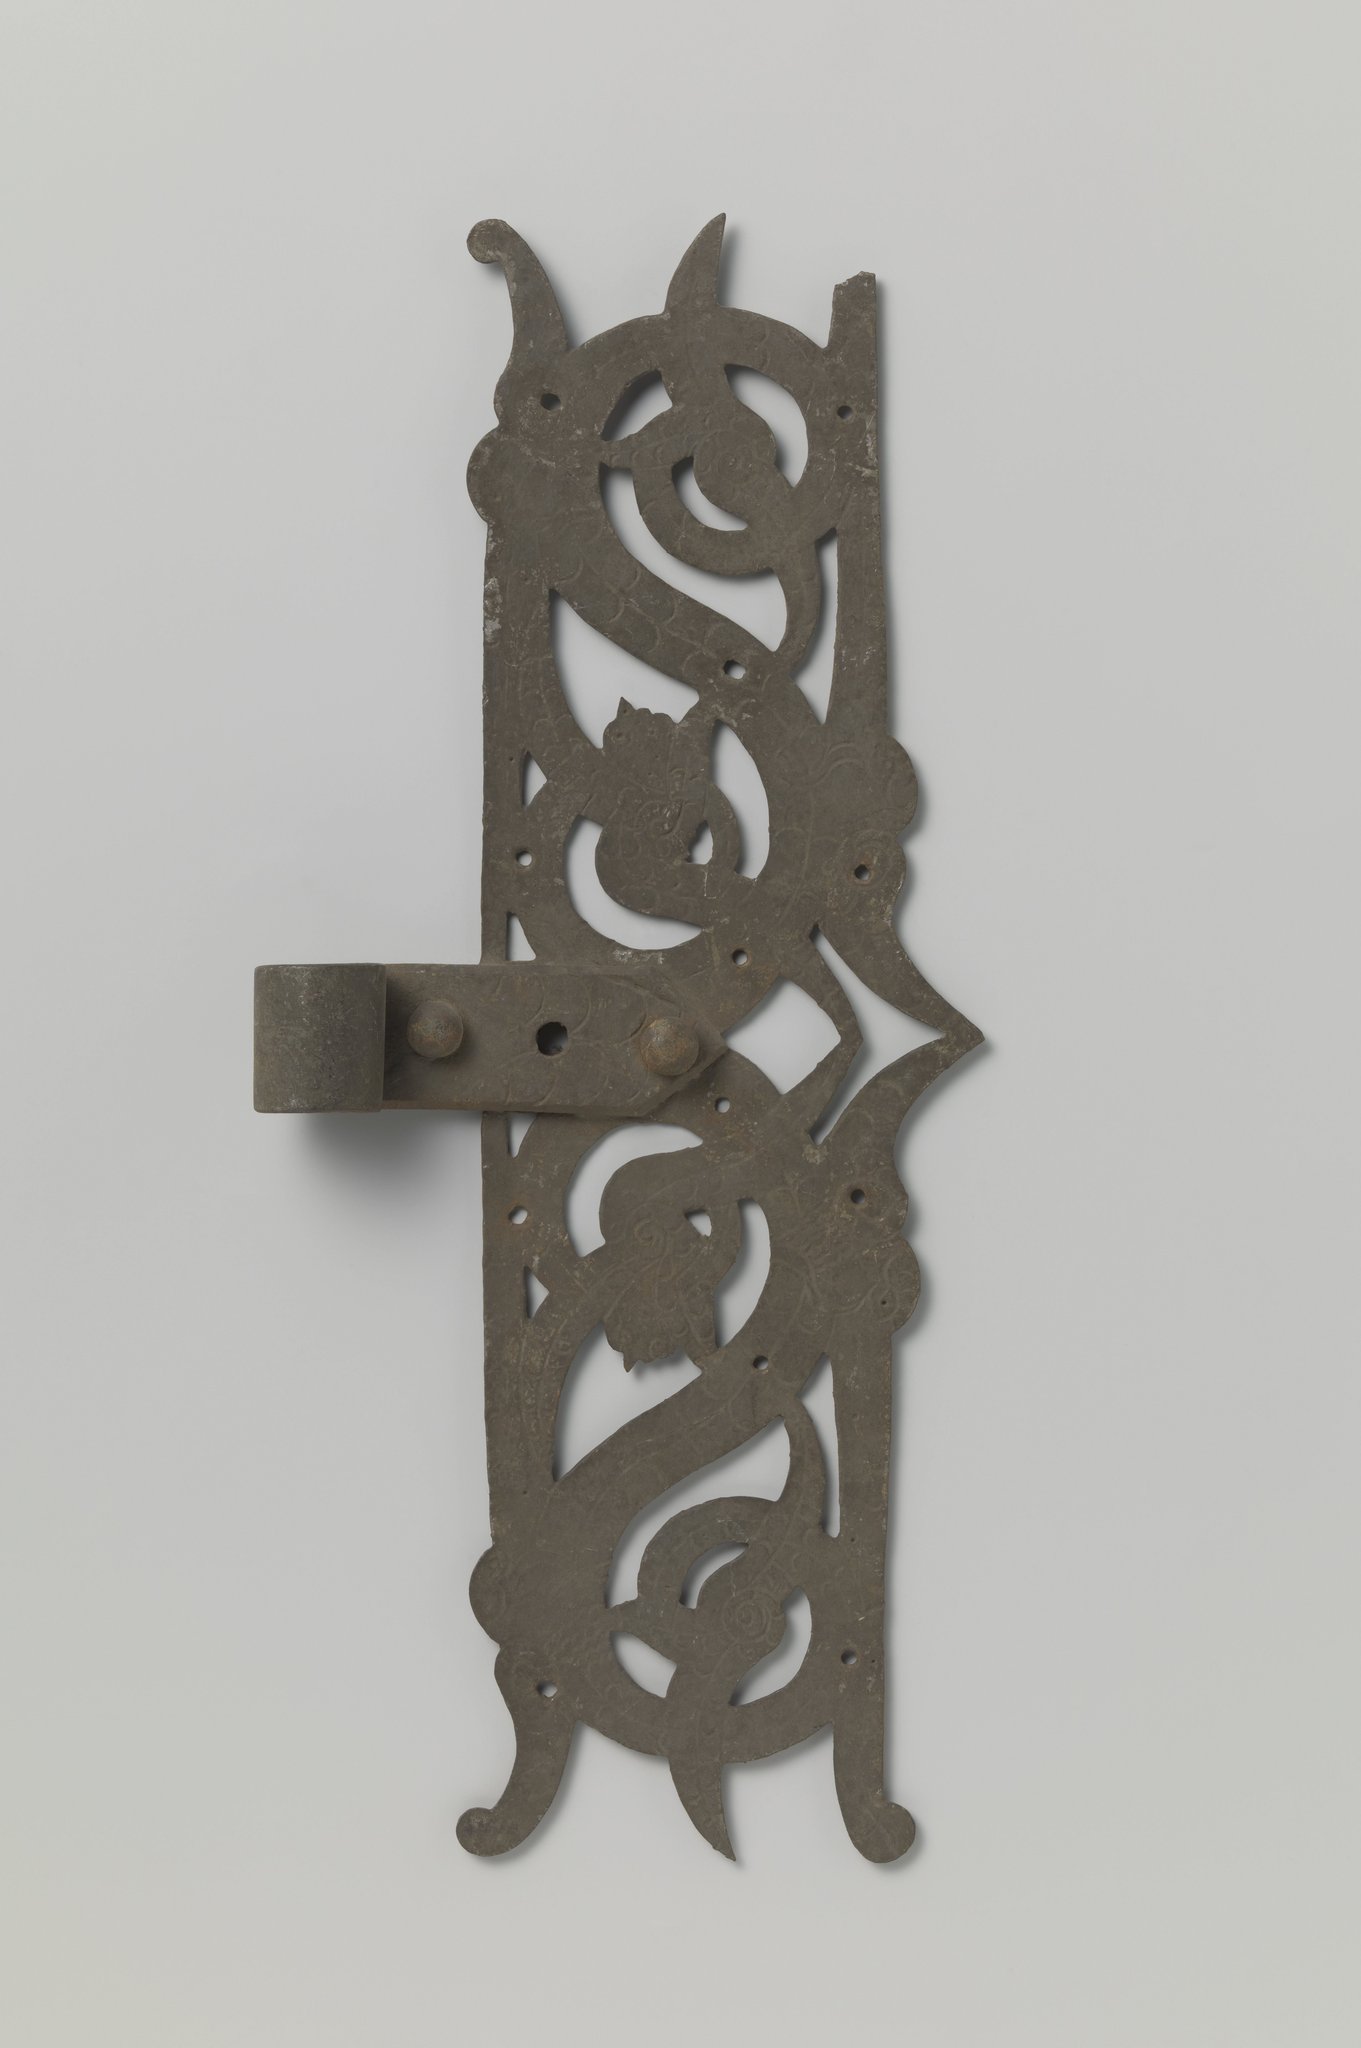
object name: hengsel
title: Hengsel van vertind ijzer met rankmotieven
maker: Anonymous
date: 1600-1700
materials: iron, tin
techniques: metalworking, tinning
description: Hengsel van vertind ijzer. Onderaan een grote, ronde opening van een scharnier met daaraan een rechte aanzet. Achter de aanzet bevindt zich het opengewerkte, symmetrische beslag met rankmotieven in voluut tussen twee rechtere banen. De bovenste baan loopt in het midden toe in een opengewerkte punt.